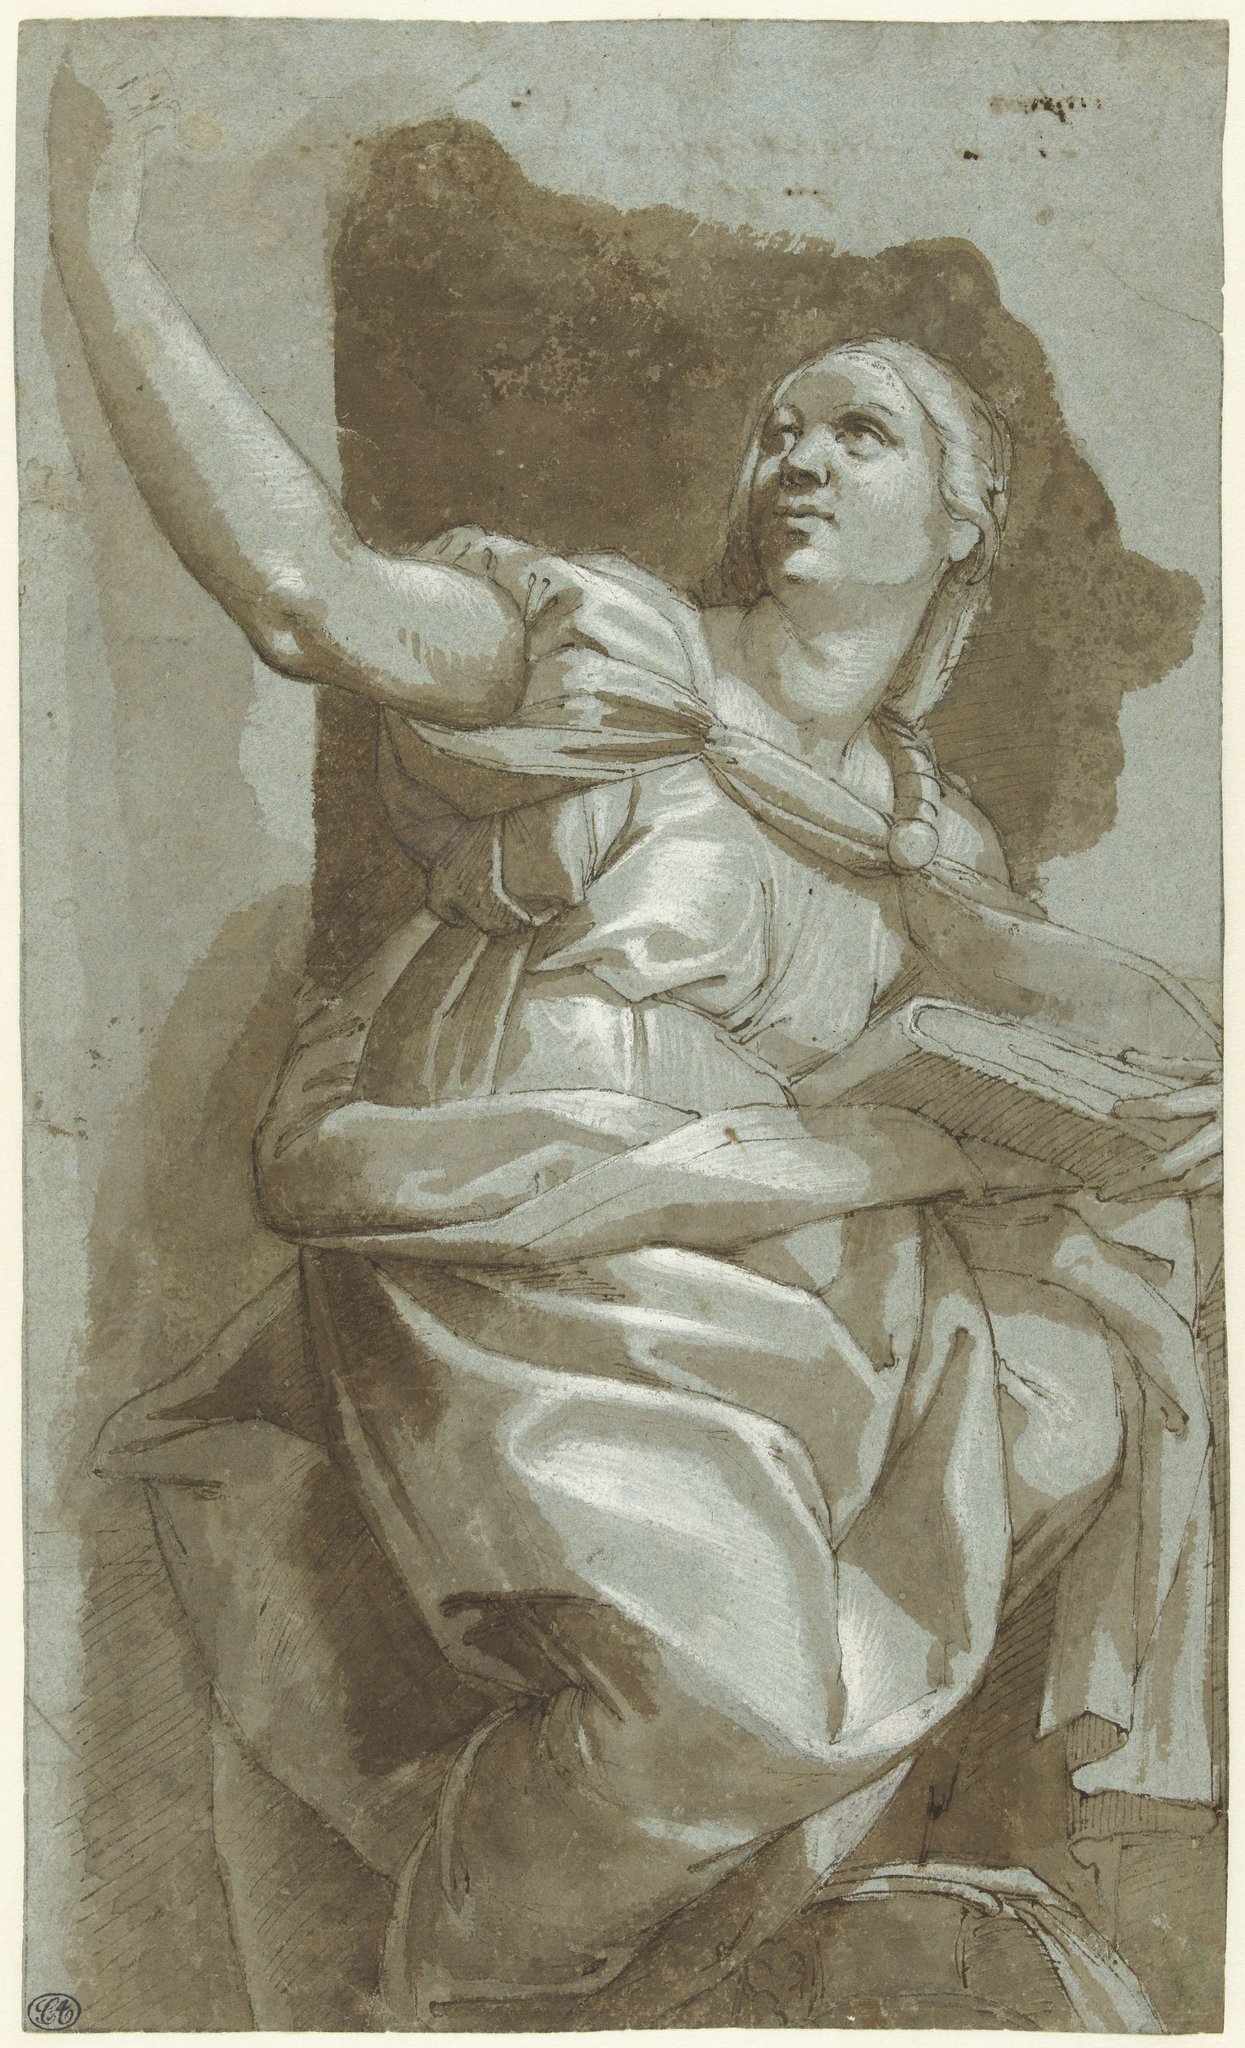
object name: drawing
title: Cumaeïsche sibylle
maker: federico barocci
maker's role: draughtsman, painter, print maker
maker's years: 1528-1612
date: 1556-1566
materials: ink, paper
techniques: brush, pen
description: Studie naar Raphael's Cumaeïsche sibylle.